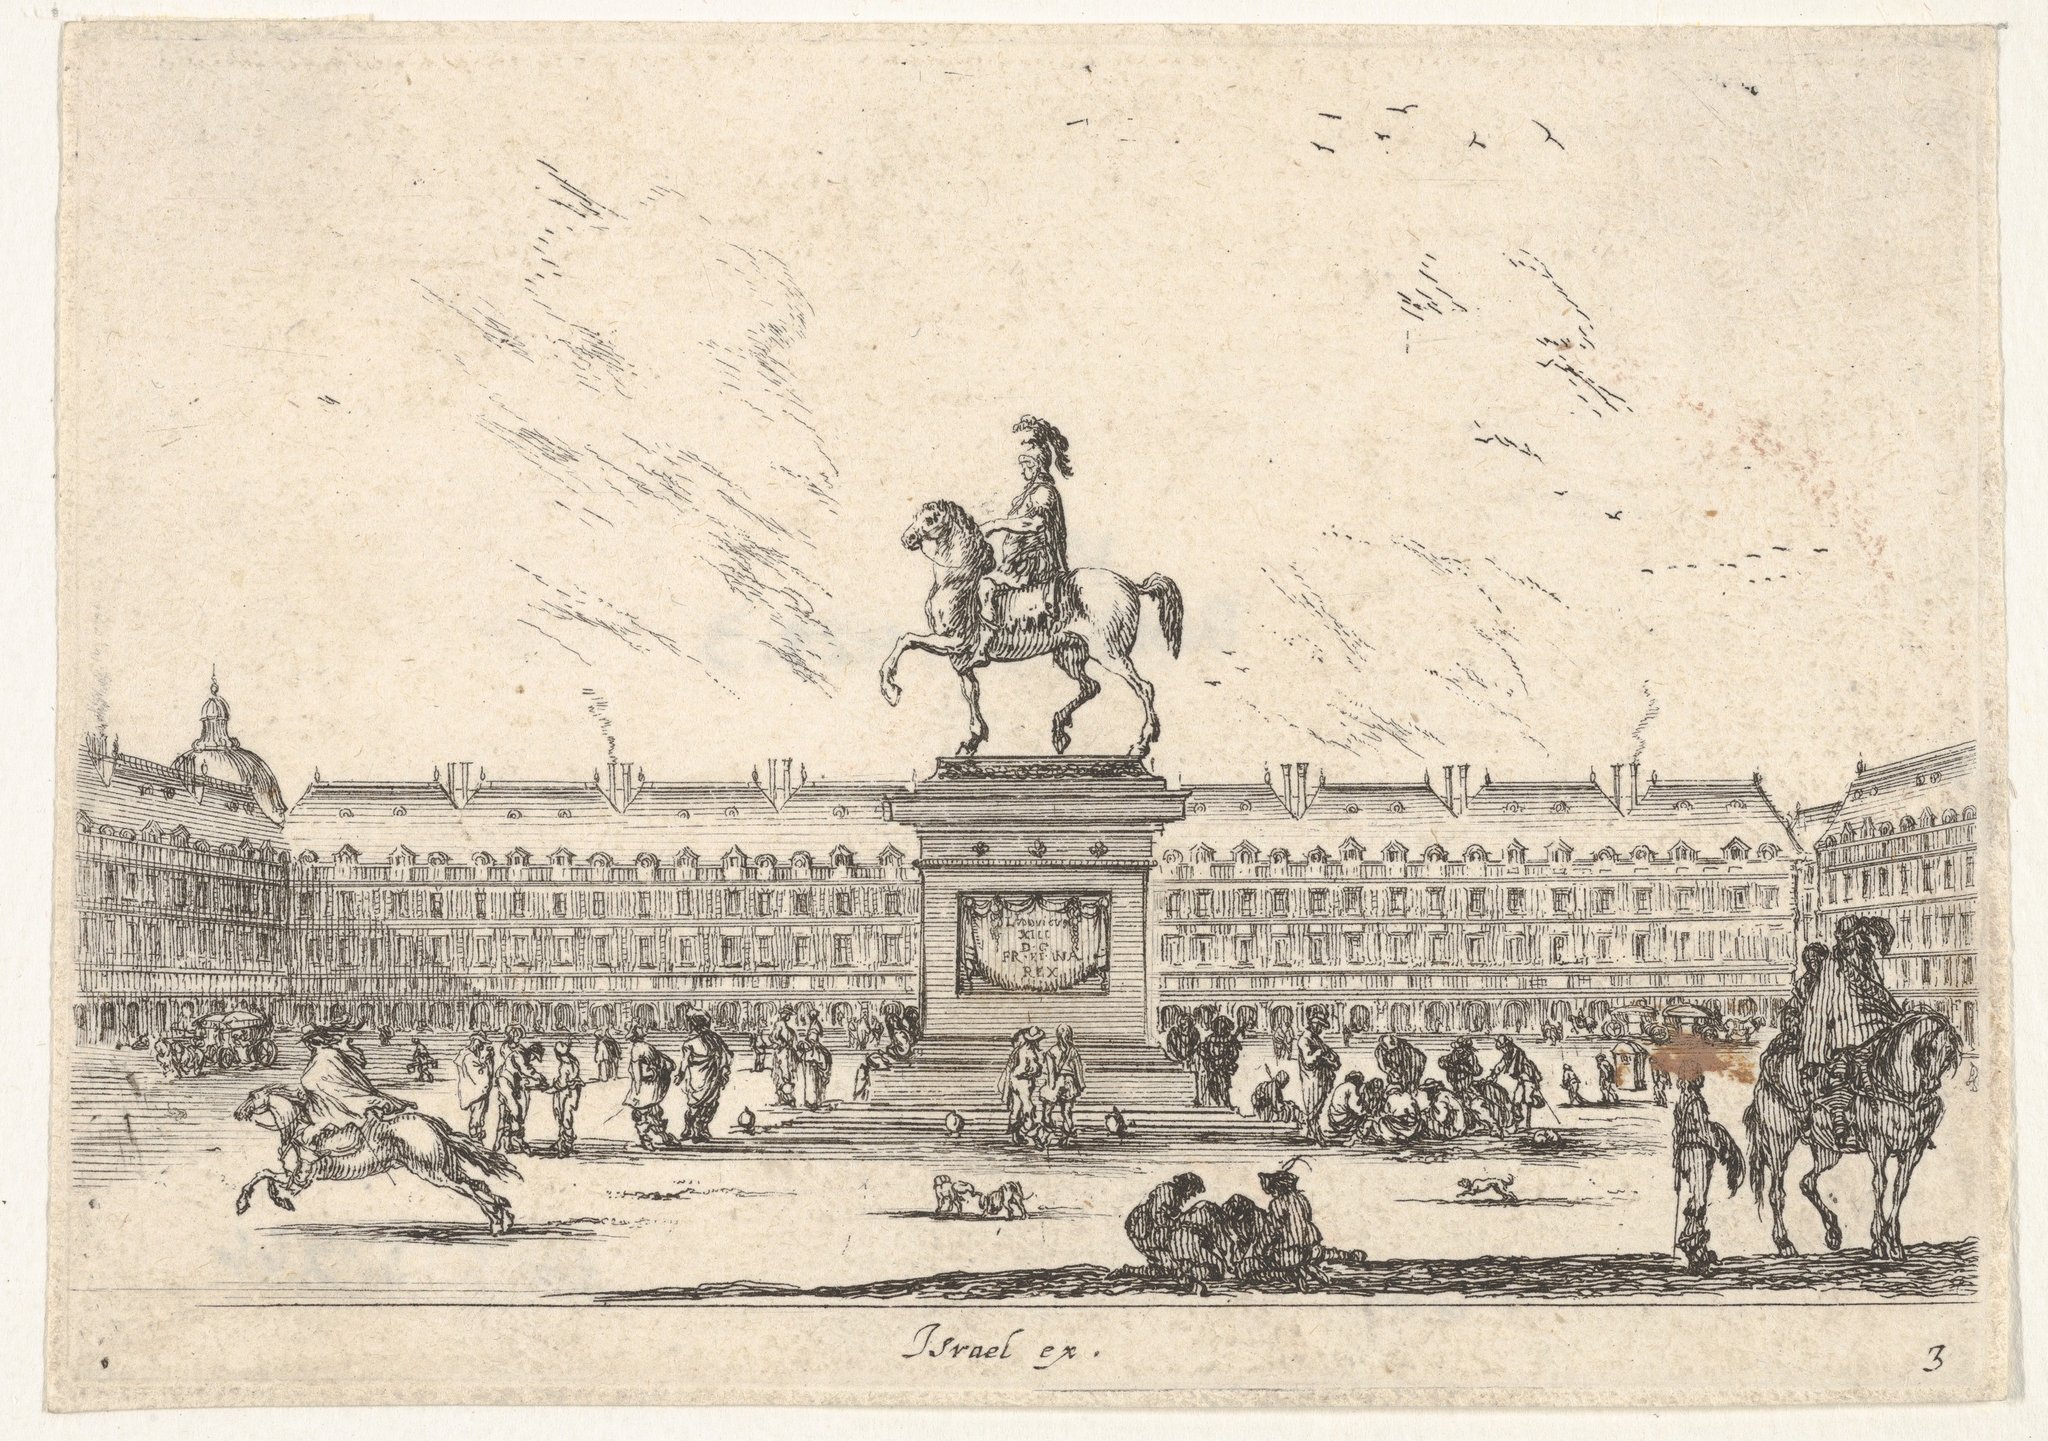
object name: print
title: Plate 3: La Place Royale, equestrian statue of Louis XIII in profile facing the left in center, various horsemen and figures in background, from "Various Figures" (Agréable diversité de figures)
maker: stefano della bella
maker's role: artist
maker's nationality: italian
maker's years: 1610-1664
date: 1642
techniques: etching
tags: buildings,monuments,men,horses